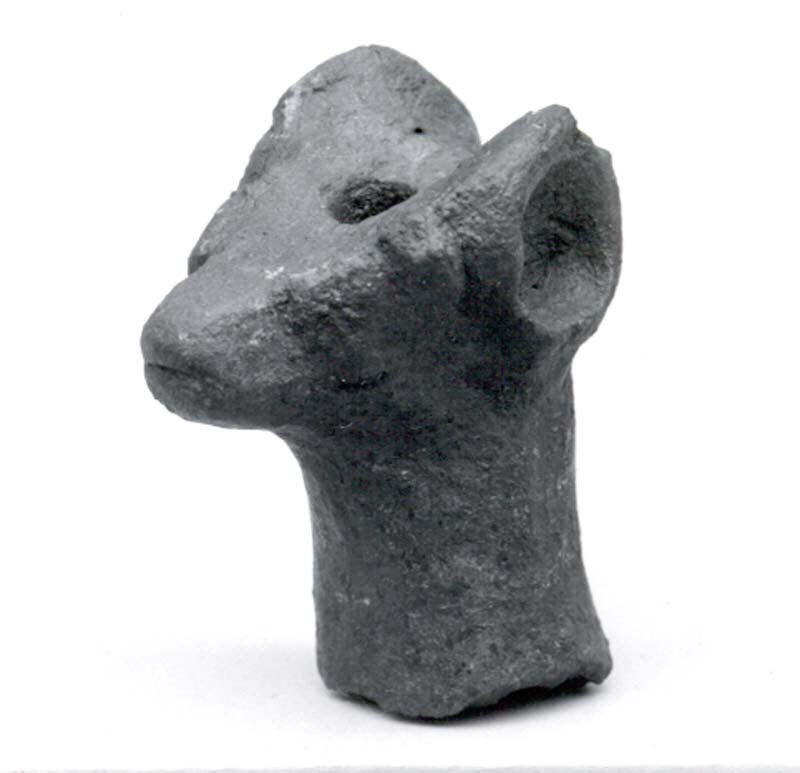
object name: spout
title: Spout in Shape of Figure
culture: sasanian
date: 201-700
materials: ceramic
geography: iran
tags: animals